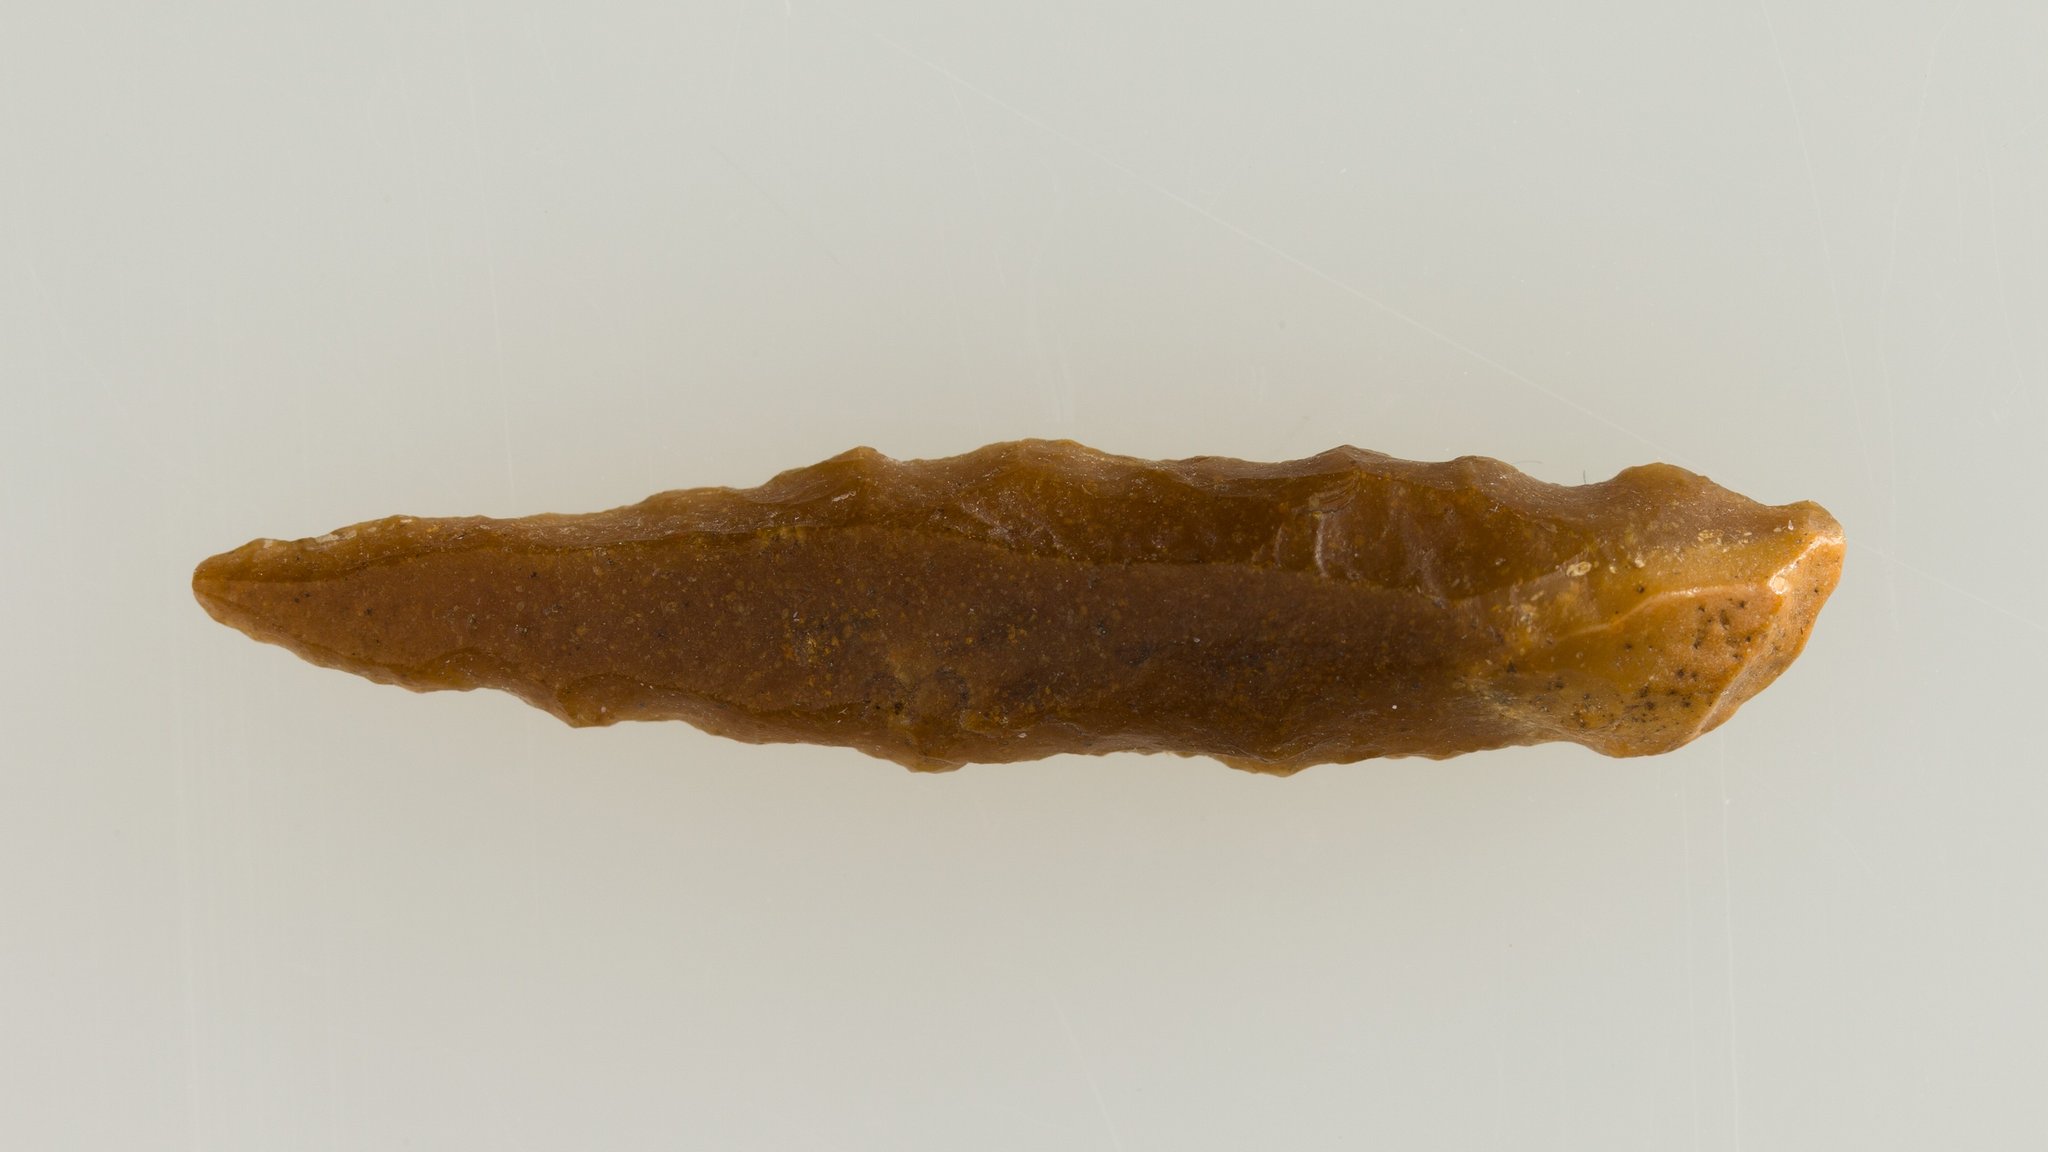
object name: tool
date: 3850-2960 BCE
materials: stone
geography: egypt